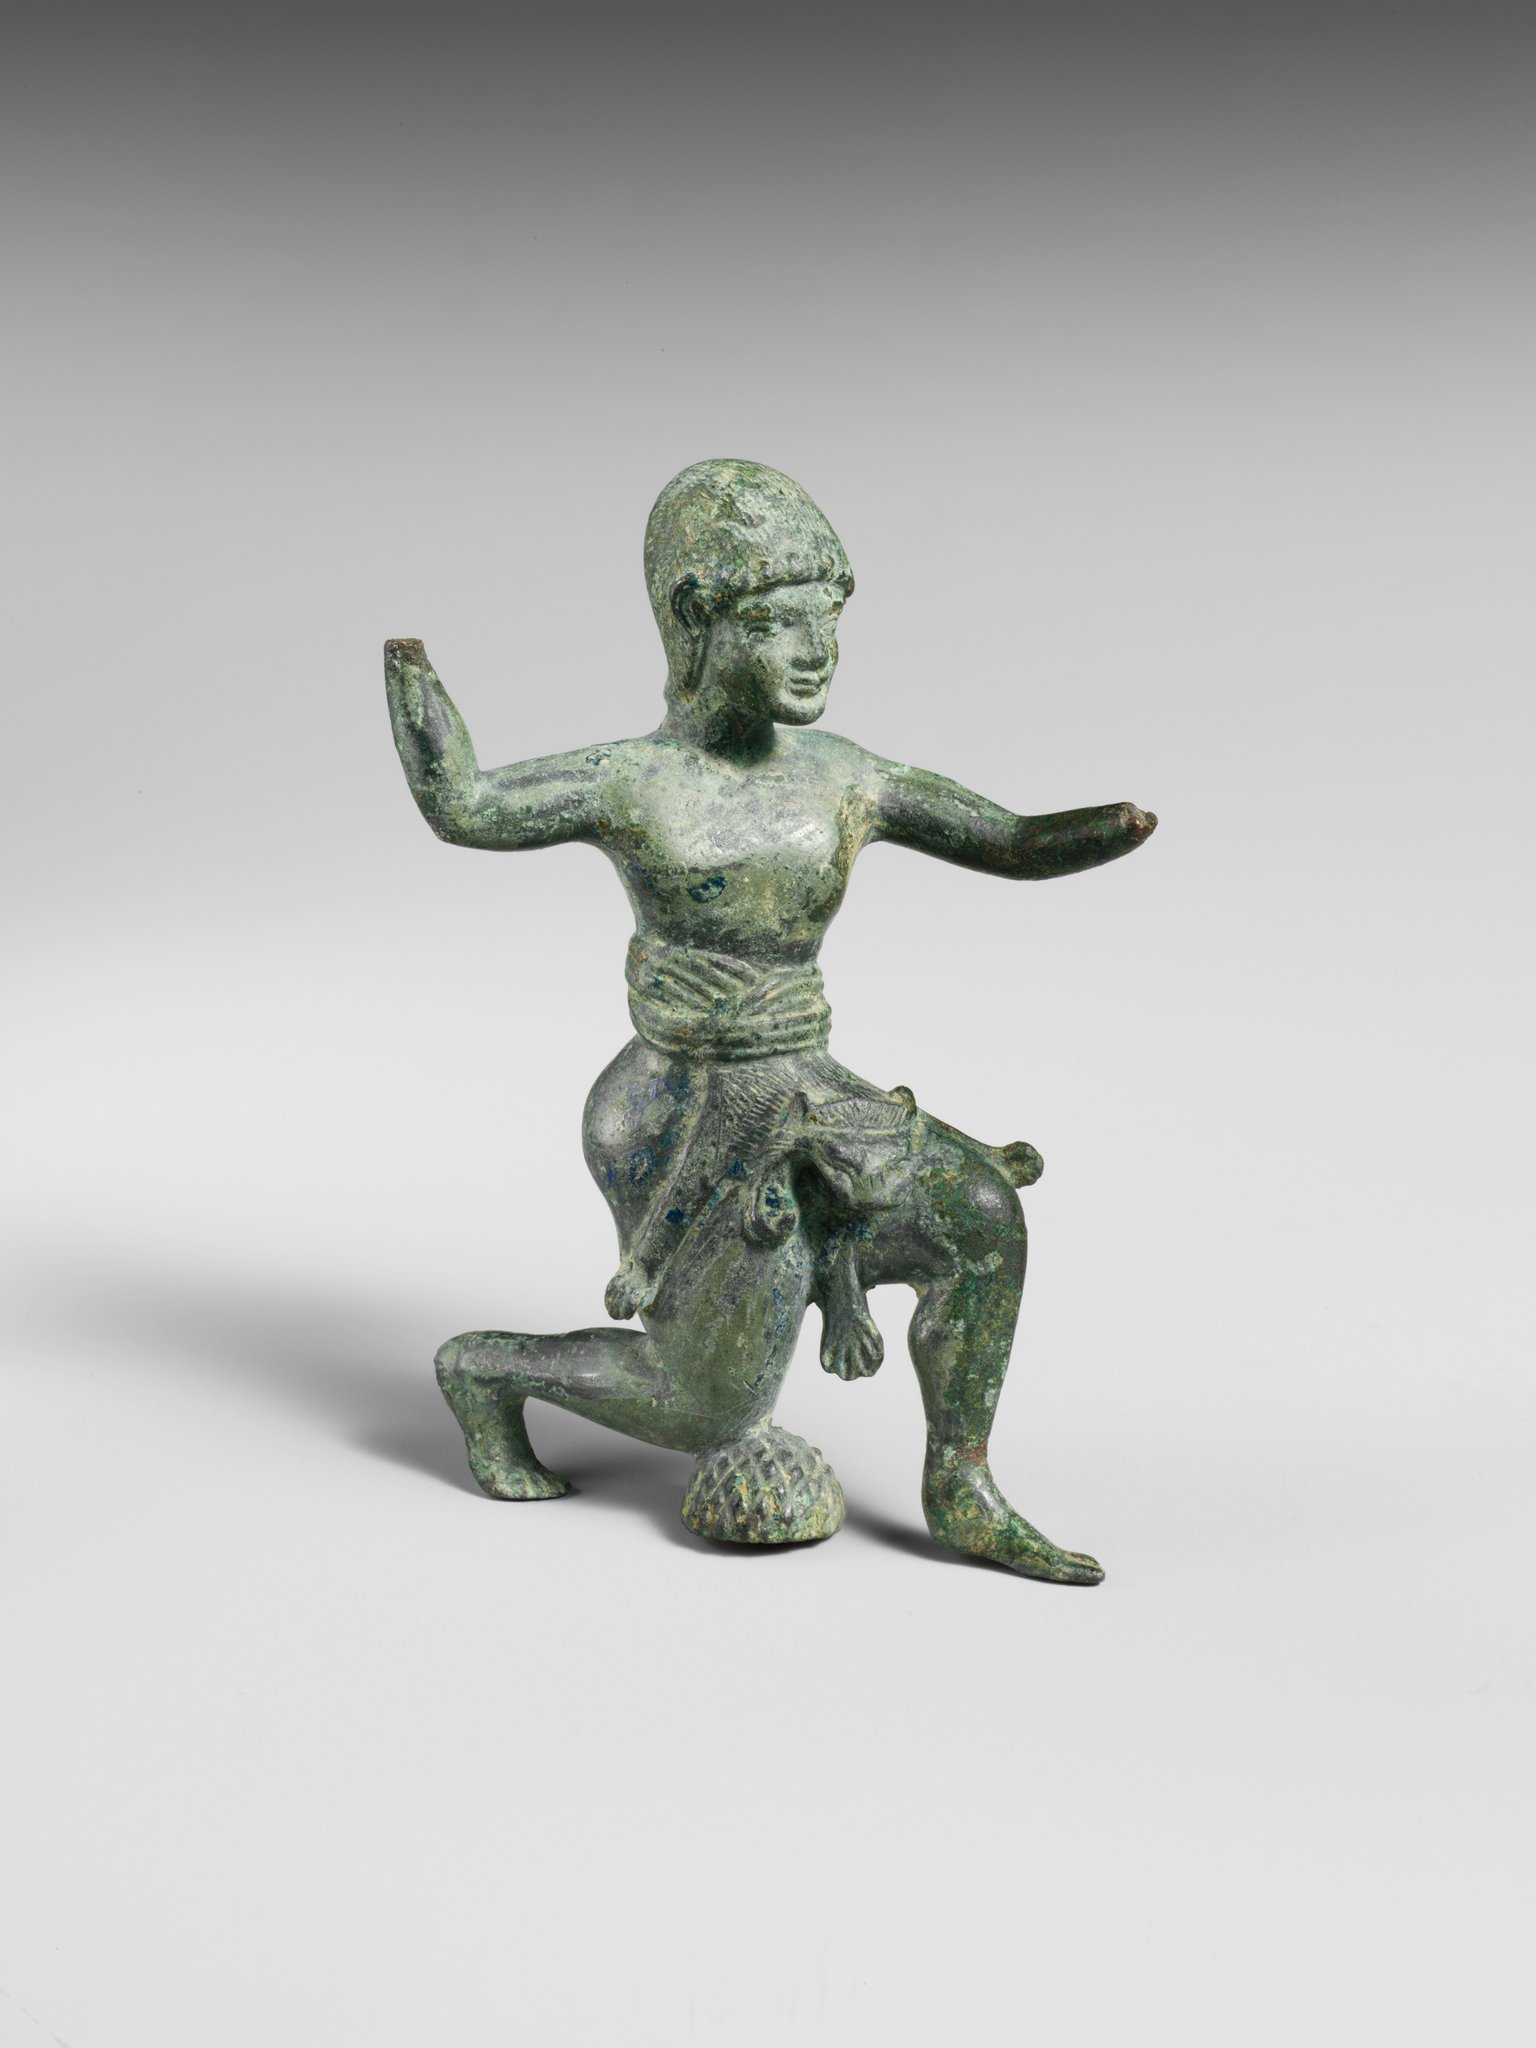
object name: statuette of herakles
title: Bronze statuette of Herakles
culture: etruscan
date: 500-475 BCE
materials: bronze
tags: herakles